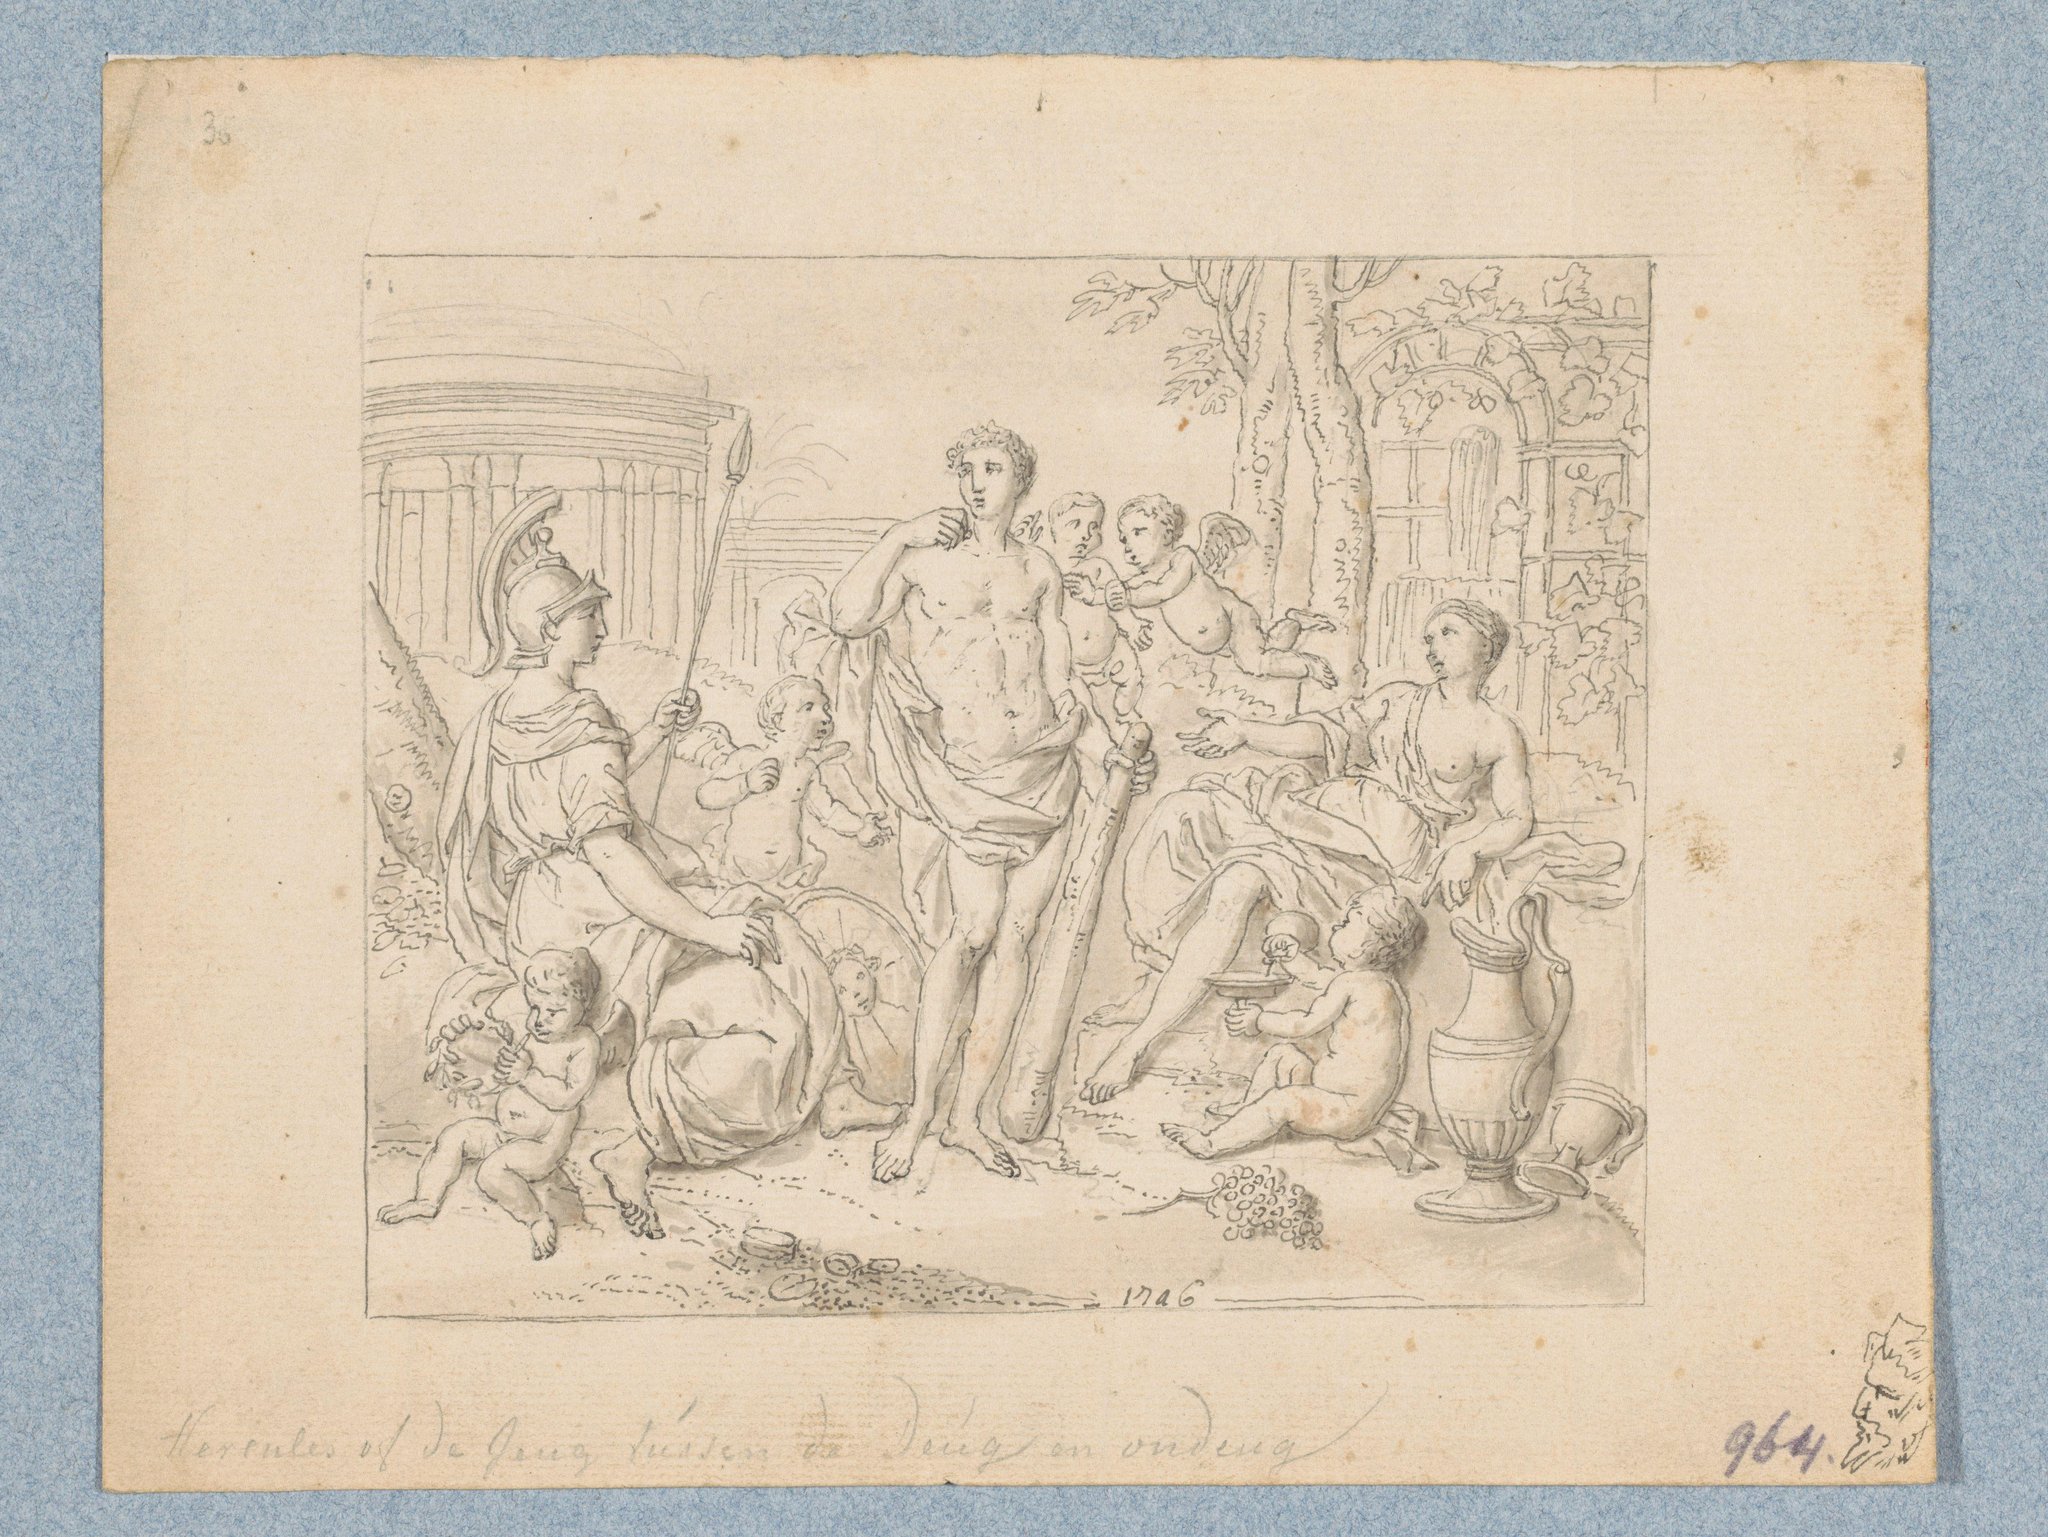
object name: drawing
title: Hercules op de tweesprong (in doos met 43 tekeningen)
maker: louis fabritius dubourg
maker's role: draughtsman, print maker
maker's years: 1693-1775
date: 1746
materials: ink, paper, pencil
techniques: brush, pen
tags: hercules at the cross-roads, 'herkules am scheidewege': the choice of hercules